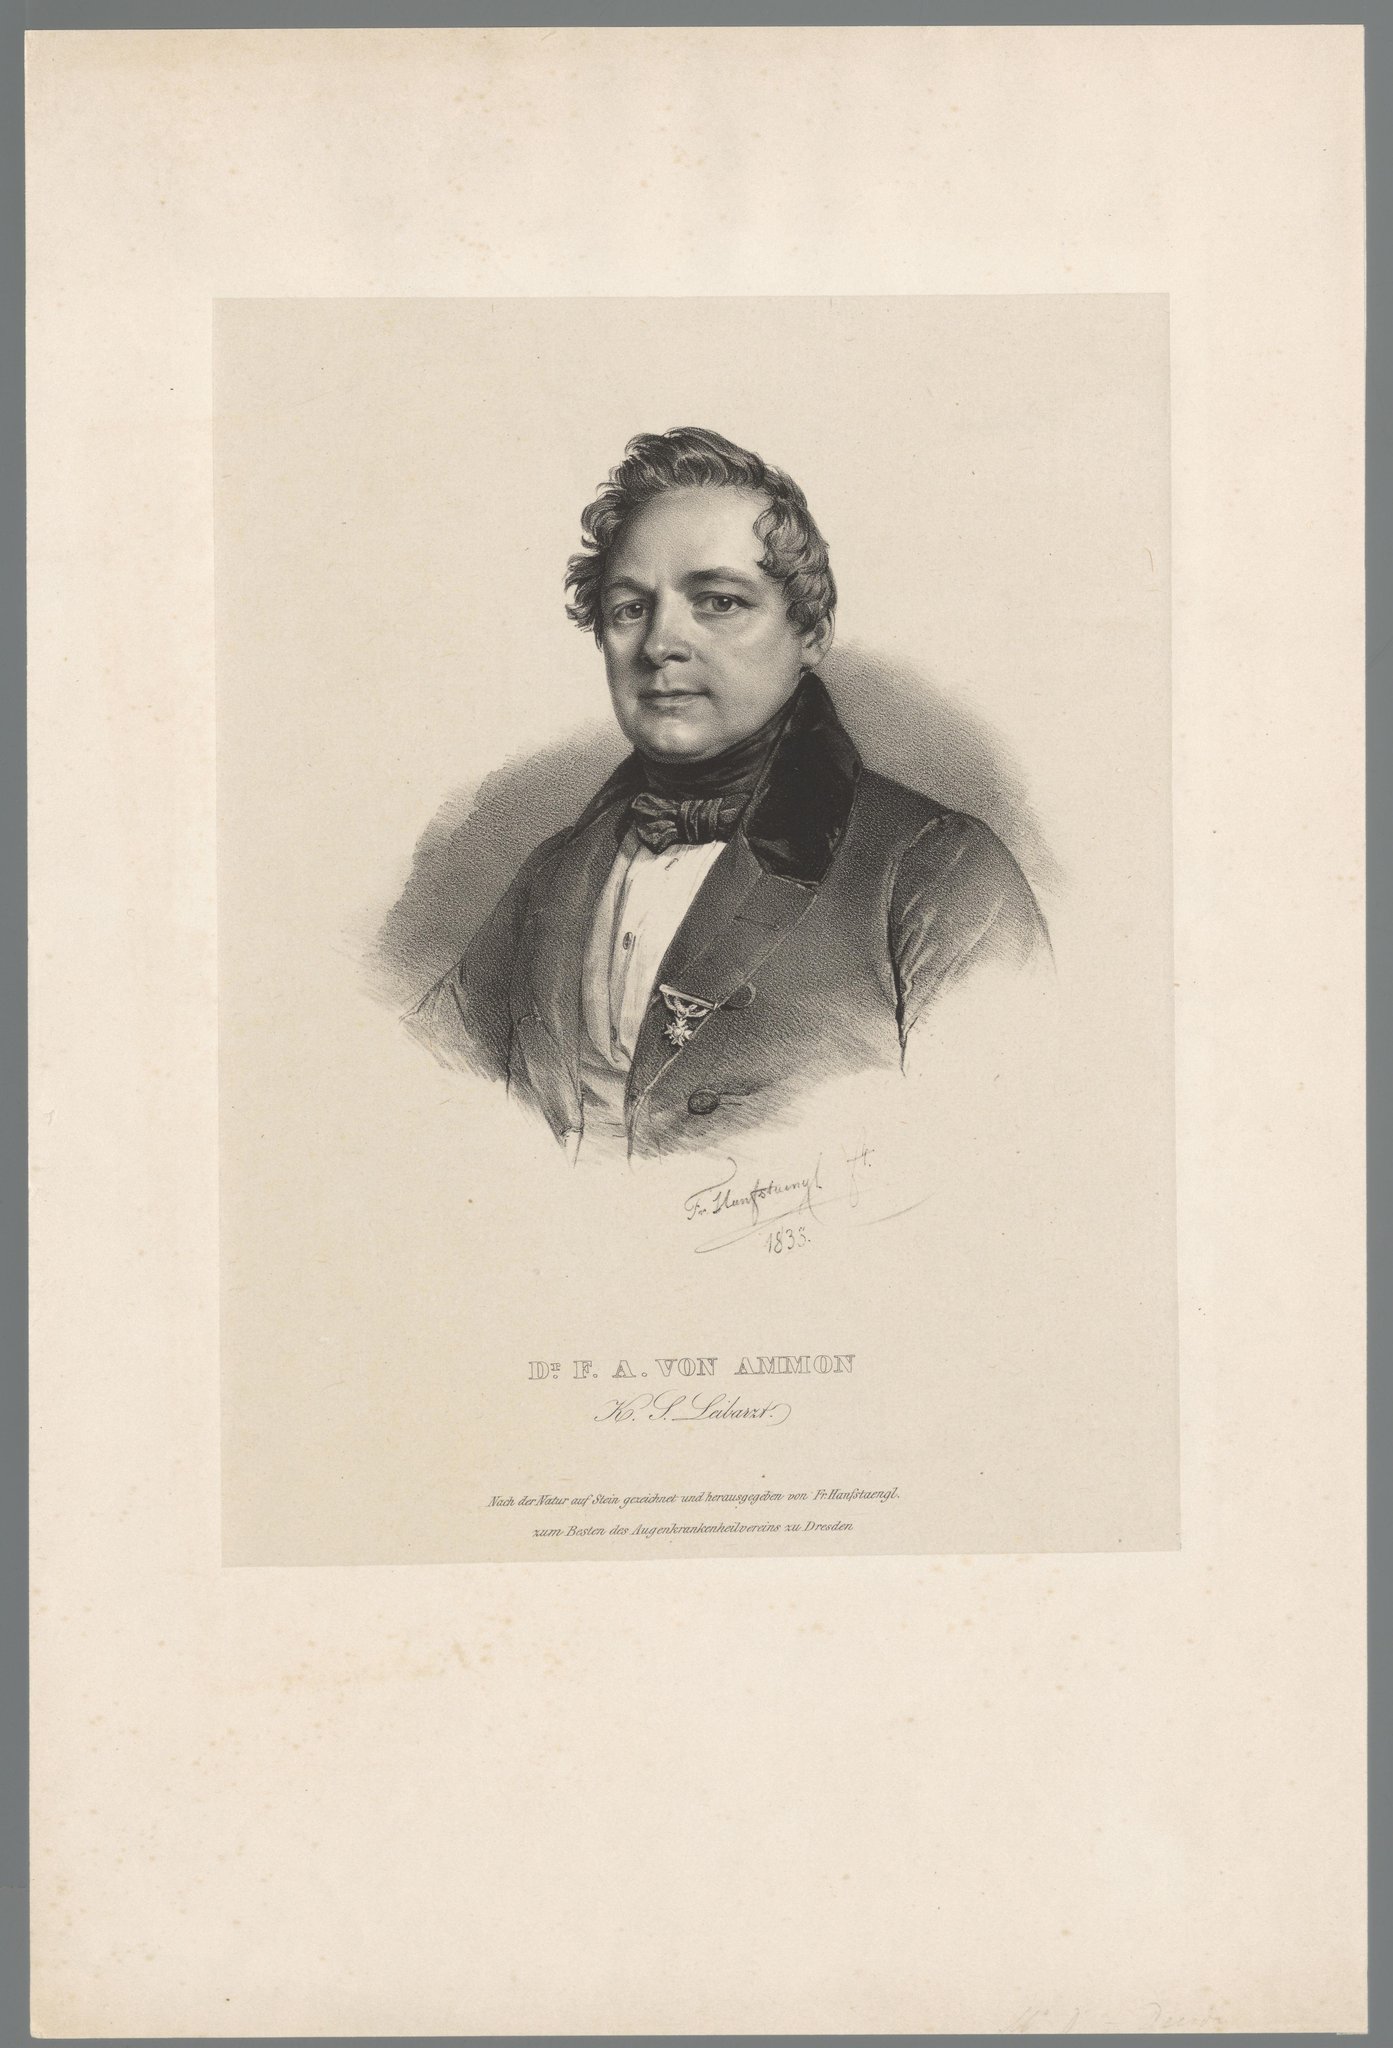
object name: print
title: Dr. F.A. von Ammon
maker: franz seraph hanfstaengl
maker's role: painter, print maker, printer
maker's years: 1804-1877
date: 1838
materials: paper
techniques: lithograph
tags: adult man, historical persons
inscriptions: collector's mark: Lugt 2228